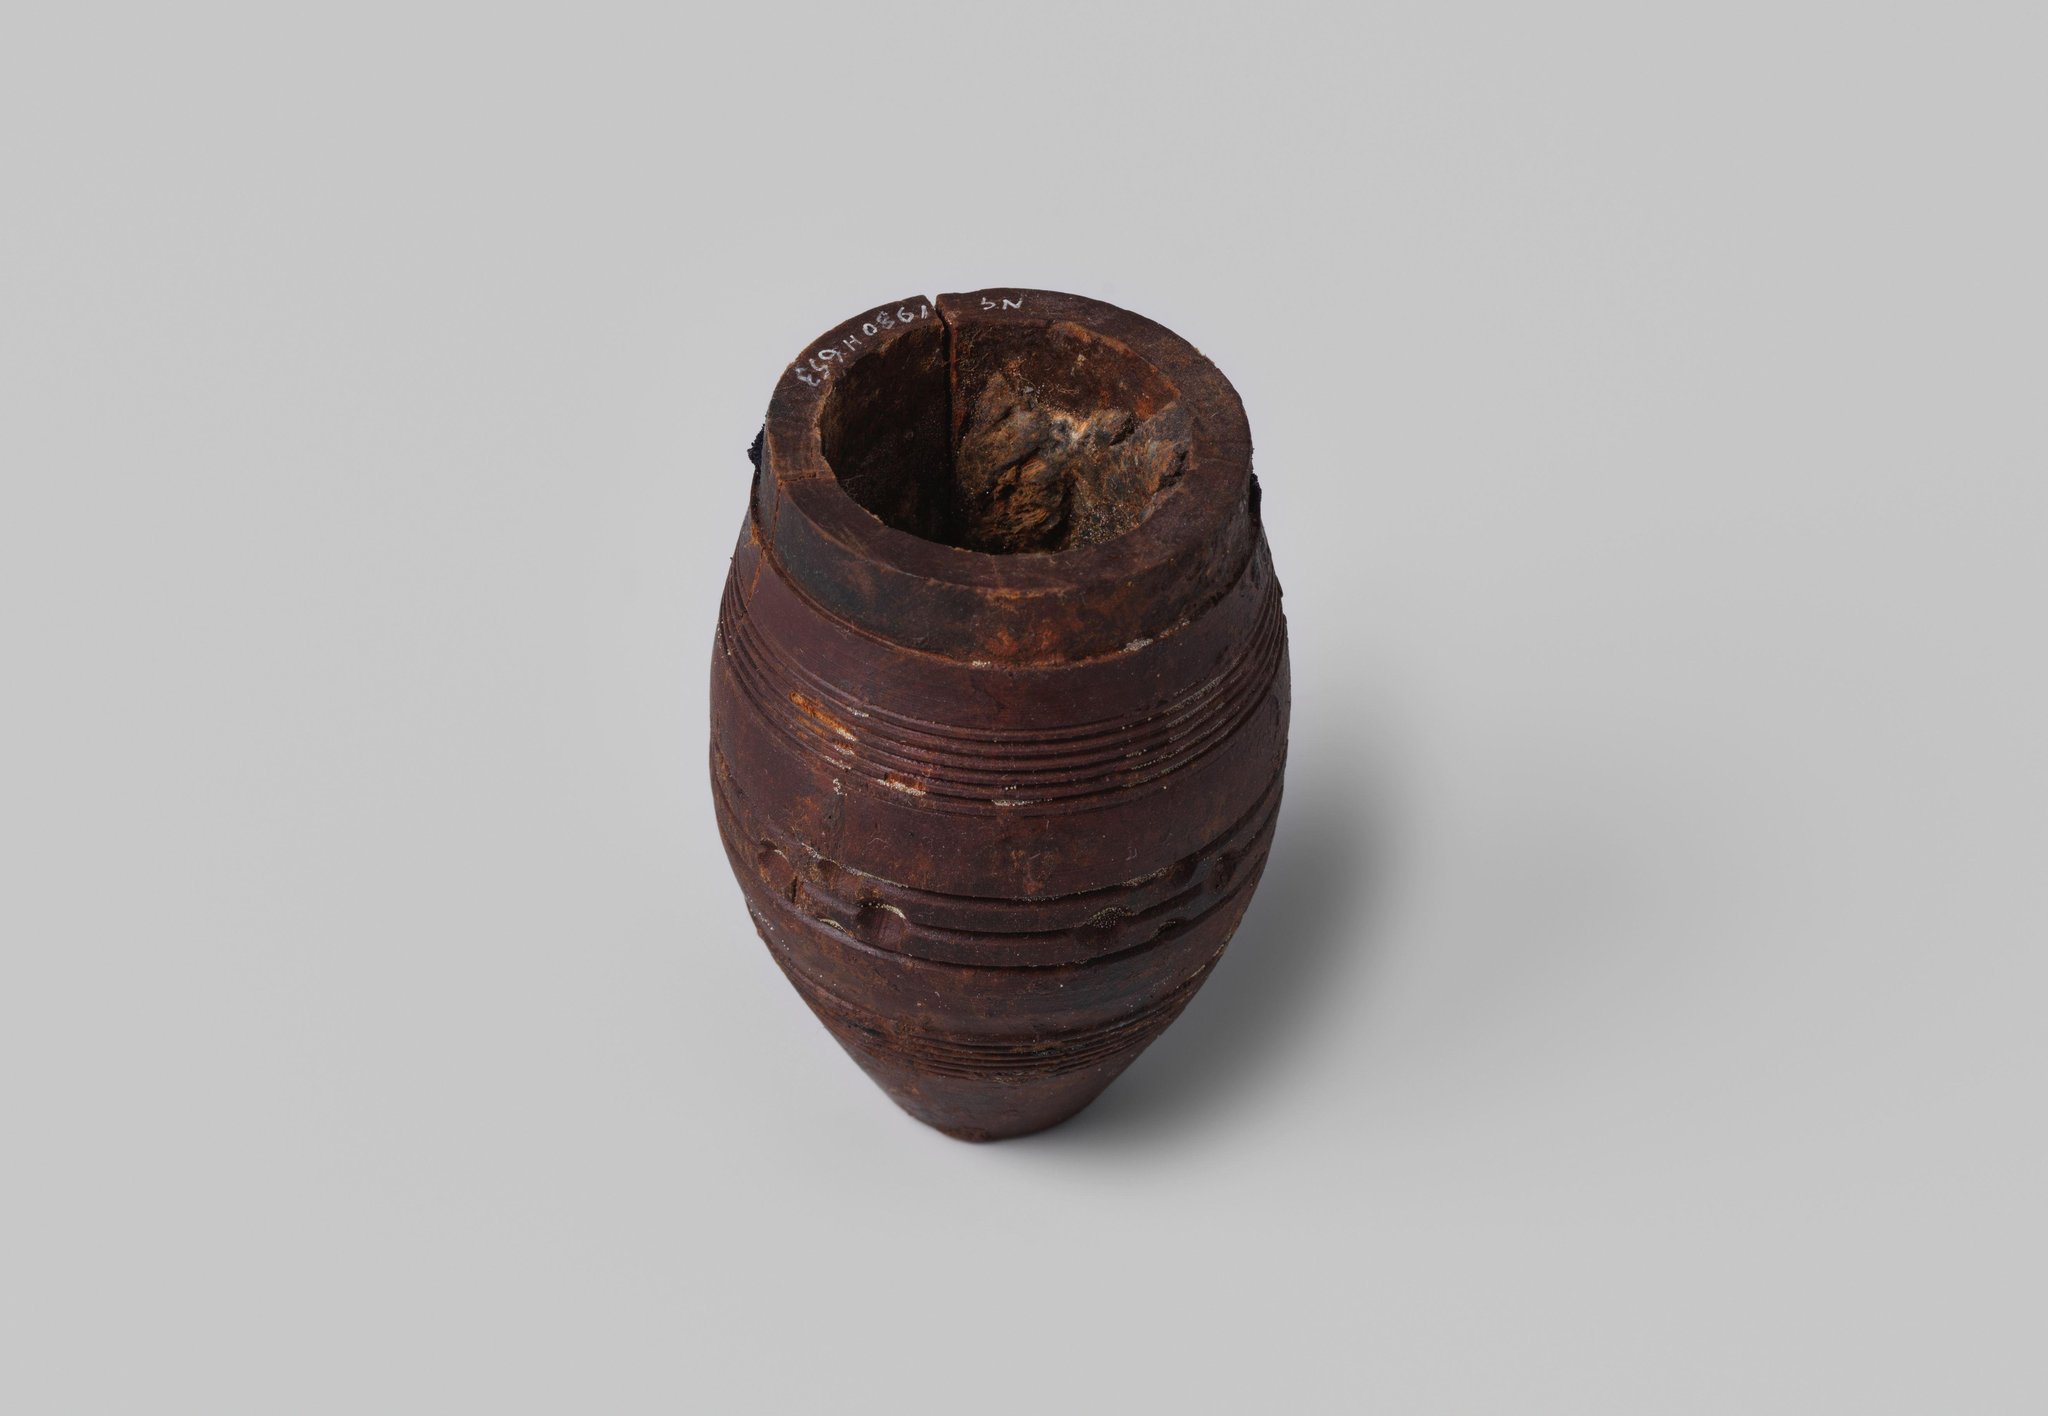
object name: pot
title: Pot uit het wrak van de Oost-Indiëvaarder Hollandia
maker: Anonymous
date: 1700-1743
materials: wood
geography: netherlands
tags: verenigde oostindische compagnie, hollandia (schip), annet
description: Pot; egg-shaped, narrow flat circular base, straight upper rim, engraved linear decoration, rim recessed to fit metal band, mounting missing.